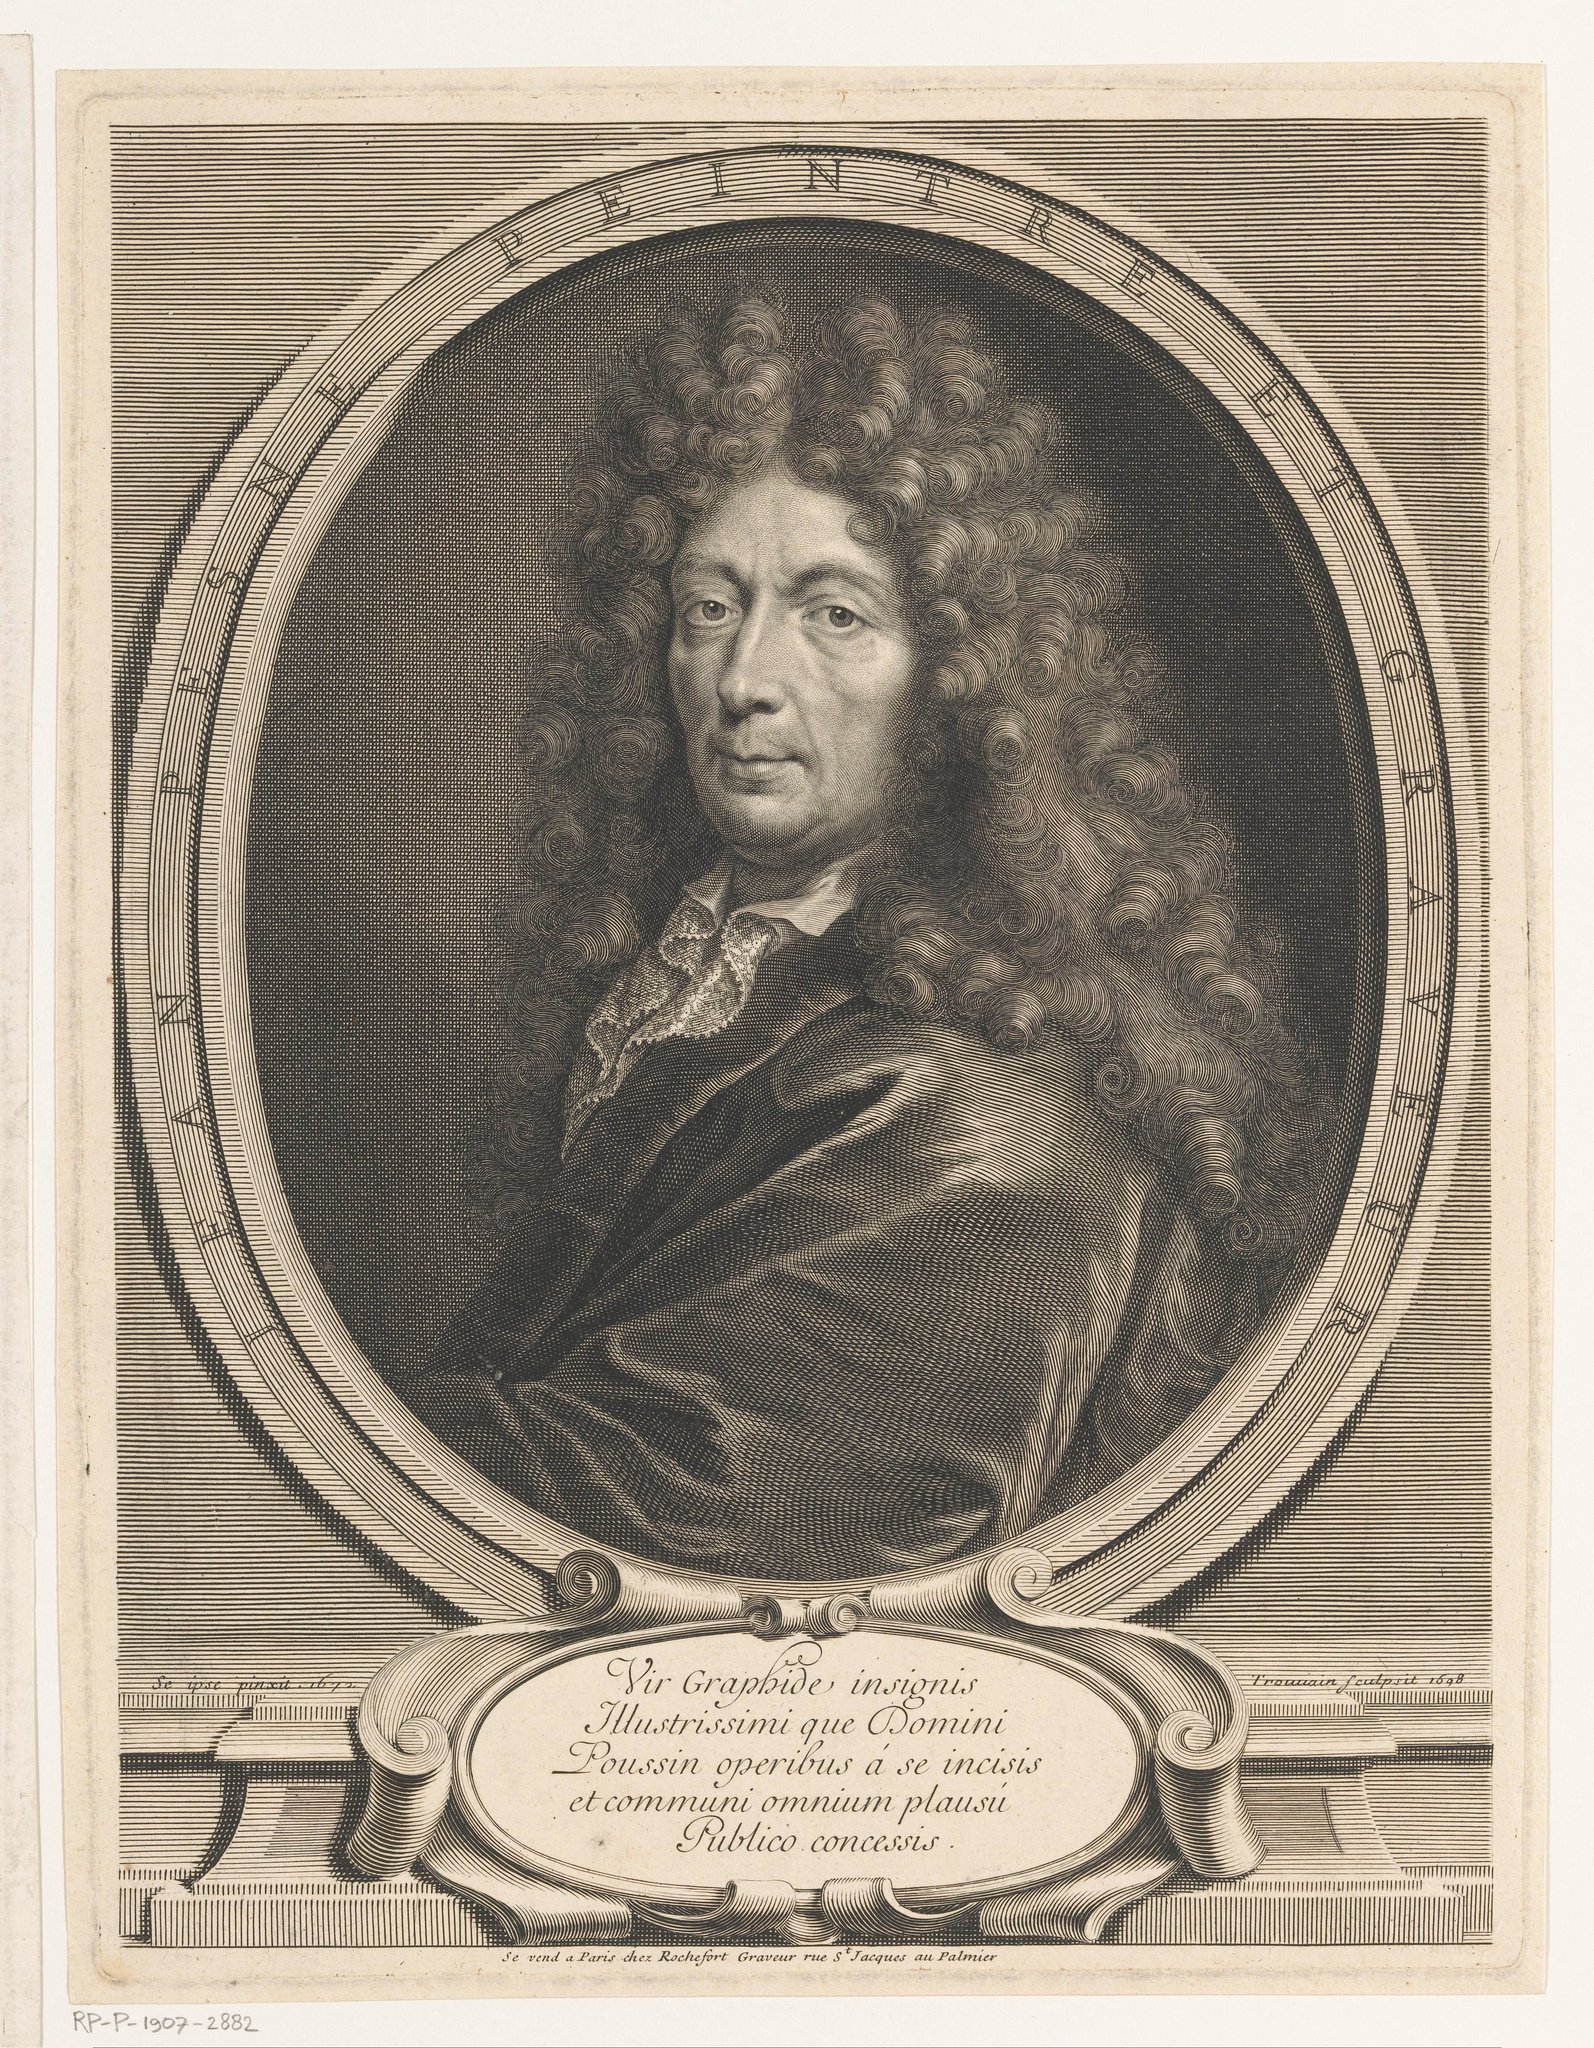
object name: print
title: Portret van Jean Pesne in ovaal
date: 1698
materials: paper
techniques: engraving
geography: france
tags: paris, print maker, jean pesne, historical persons, portrait, self-portrait of painter, wig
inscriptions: collector's mark: Lugt 2228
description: Het zelfportret door Pesne is dateert uit 1672.